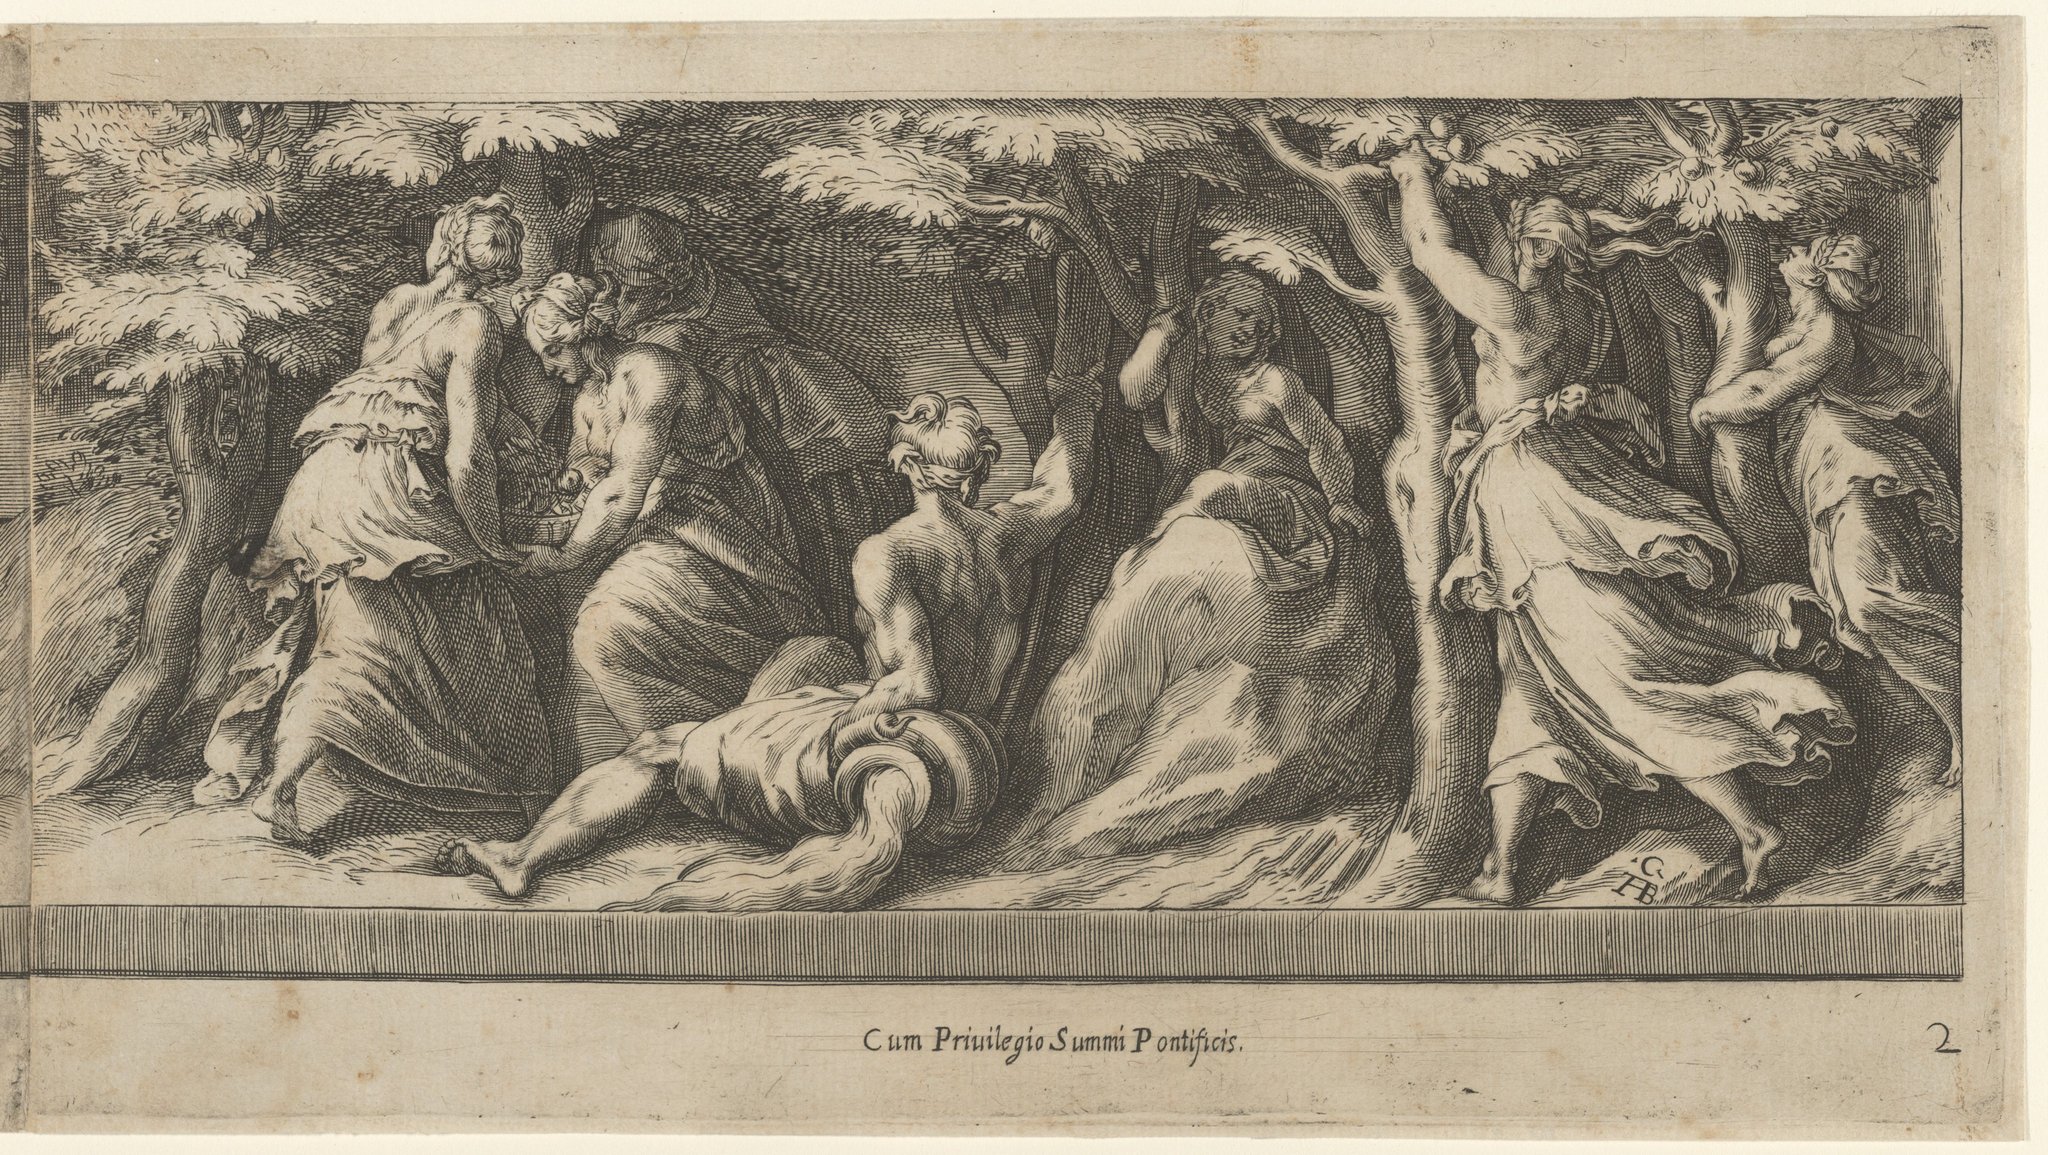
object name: print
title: The taking of the Golden Apples, from Perseus and the Golden Apples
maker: cherubino alberti (zaccaria mattia)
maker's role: artist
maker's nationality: italian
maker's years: 1553-1615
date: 1570-1615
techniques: engraving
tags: apples,female nudes,perseus